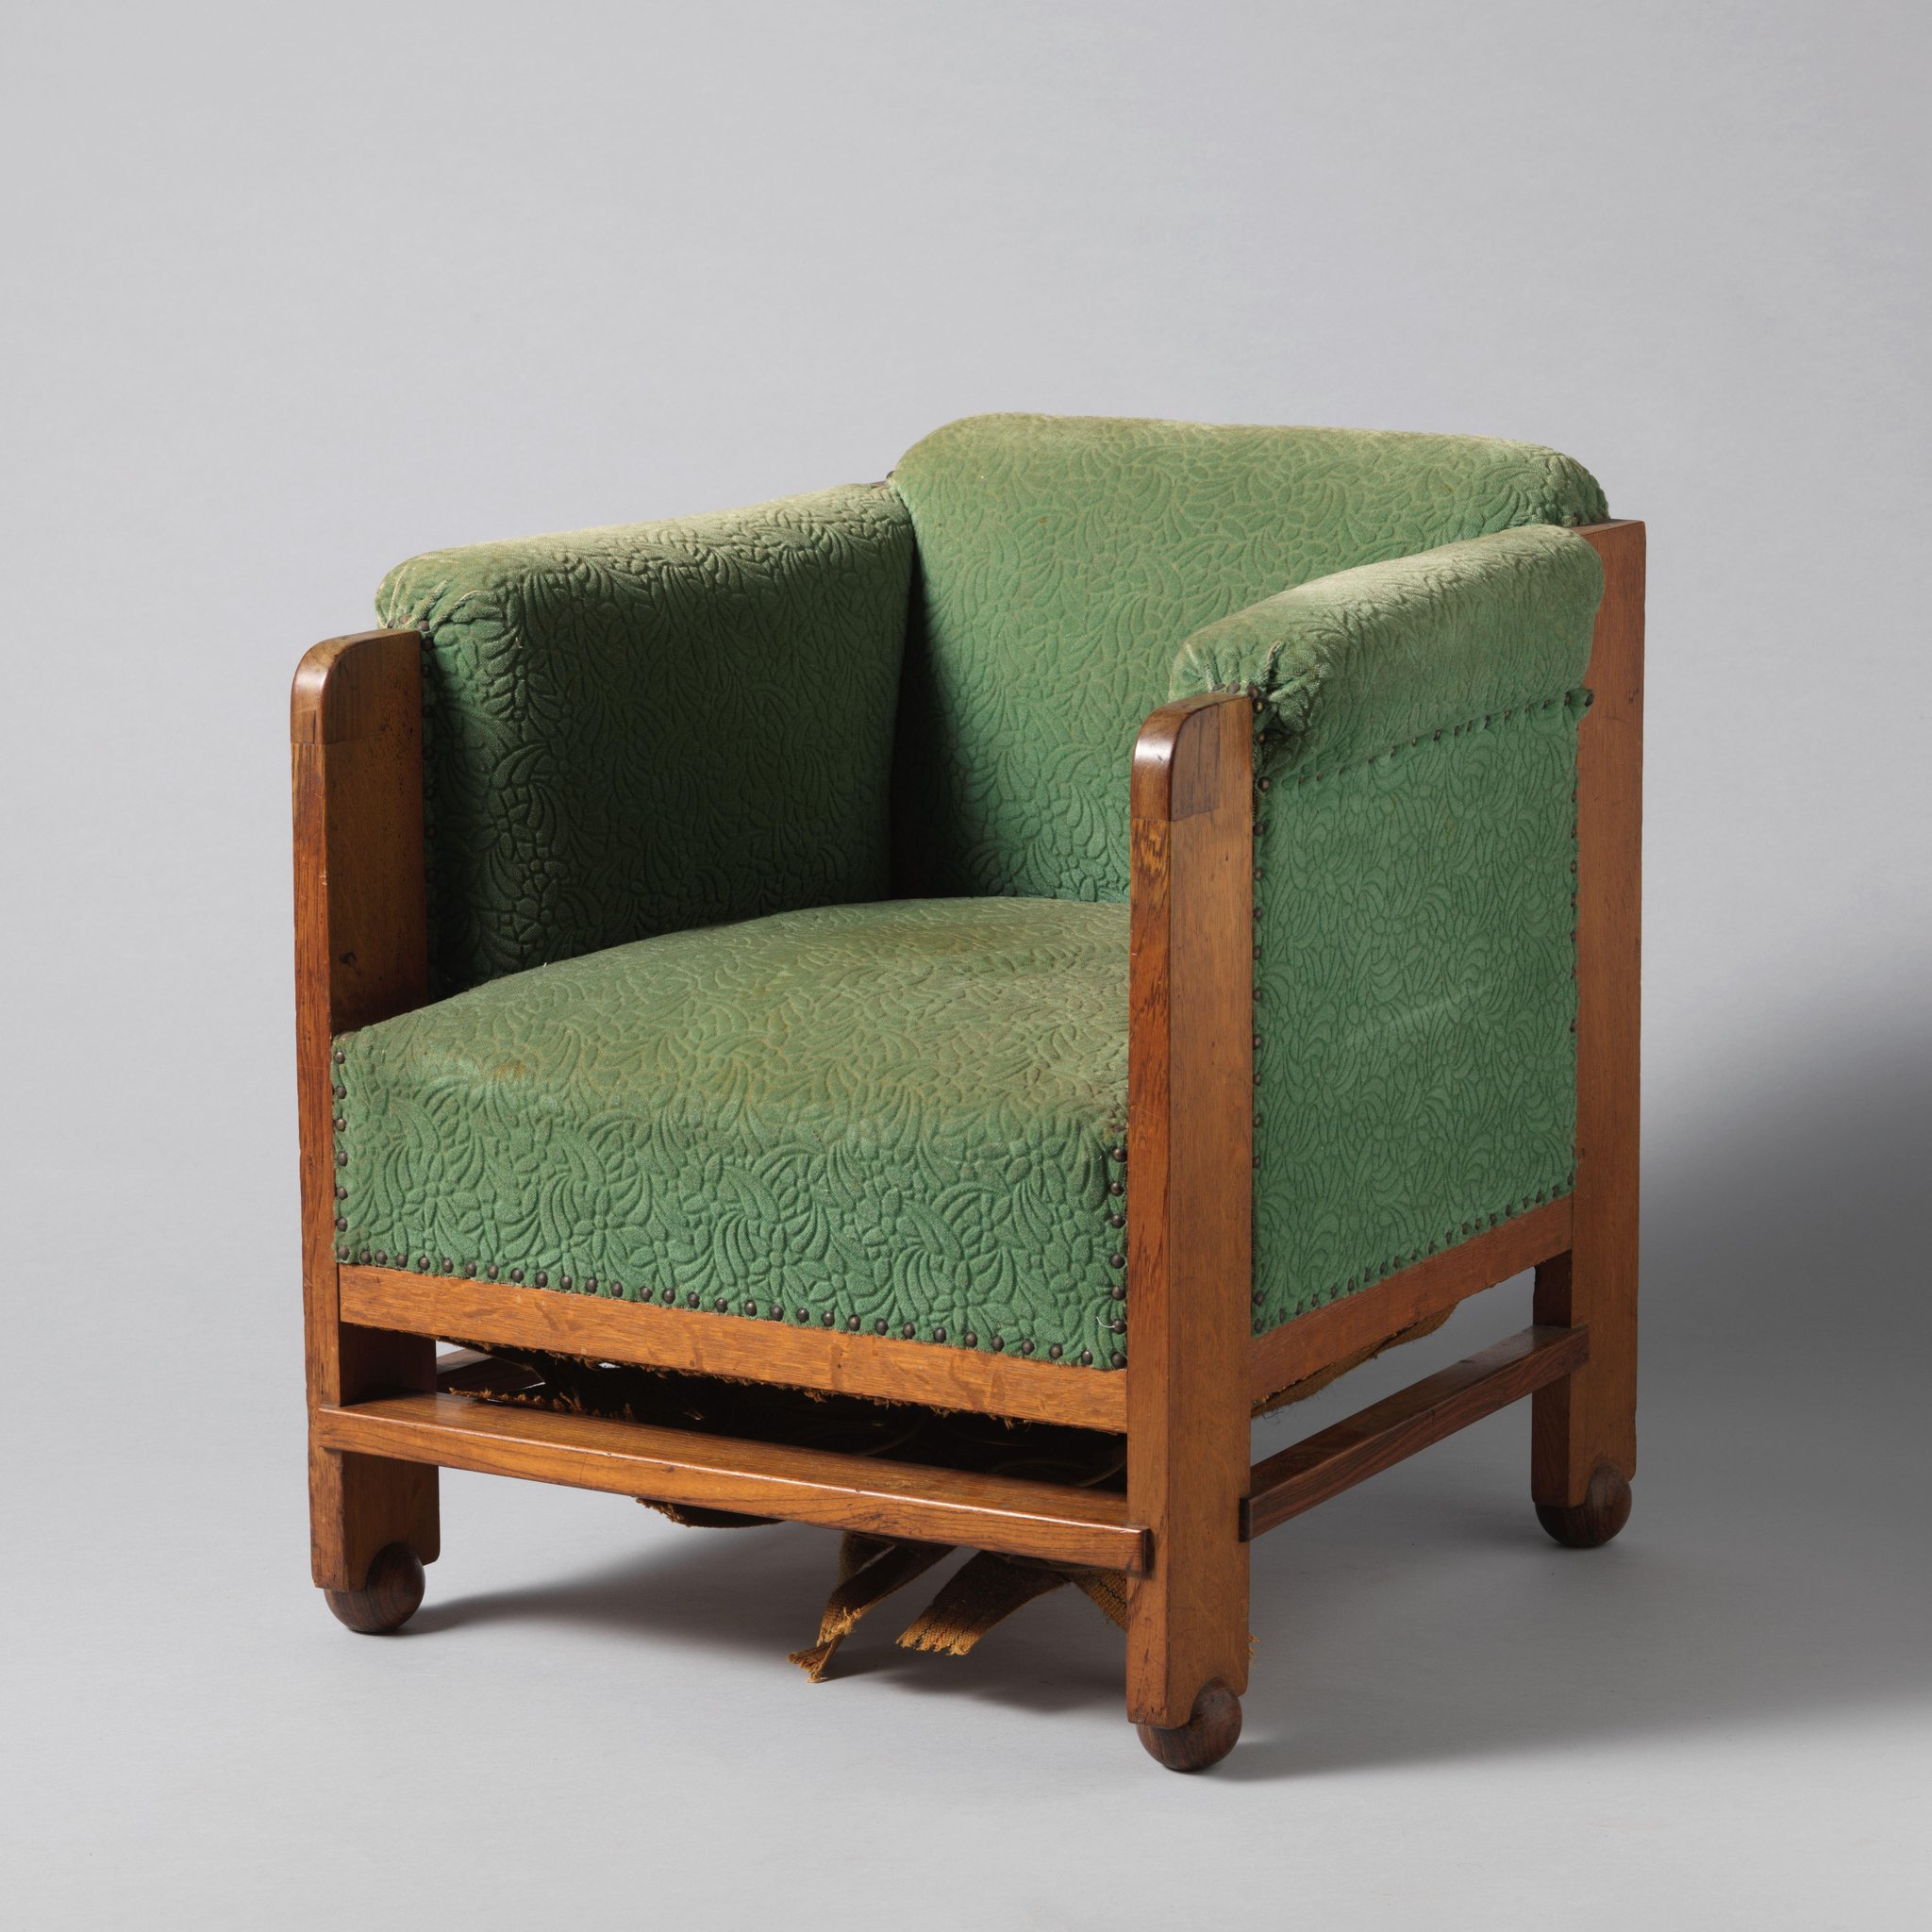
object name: seating furniture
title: Fauteuil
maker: ernst schubad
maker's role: interieurontwerper, meubelontwerper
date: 1910-1927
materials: wood, wool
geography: netherlands